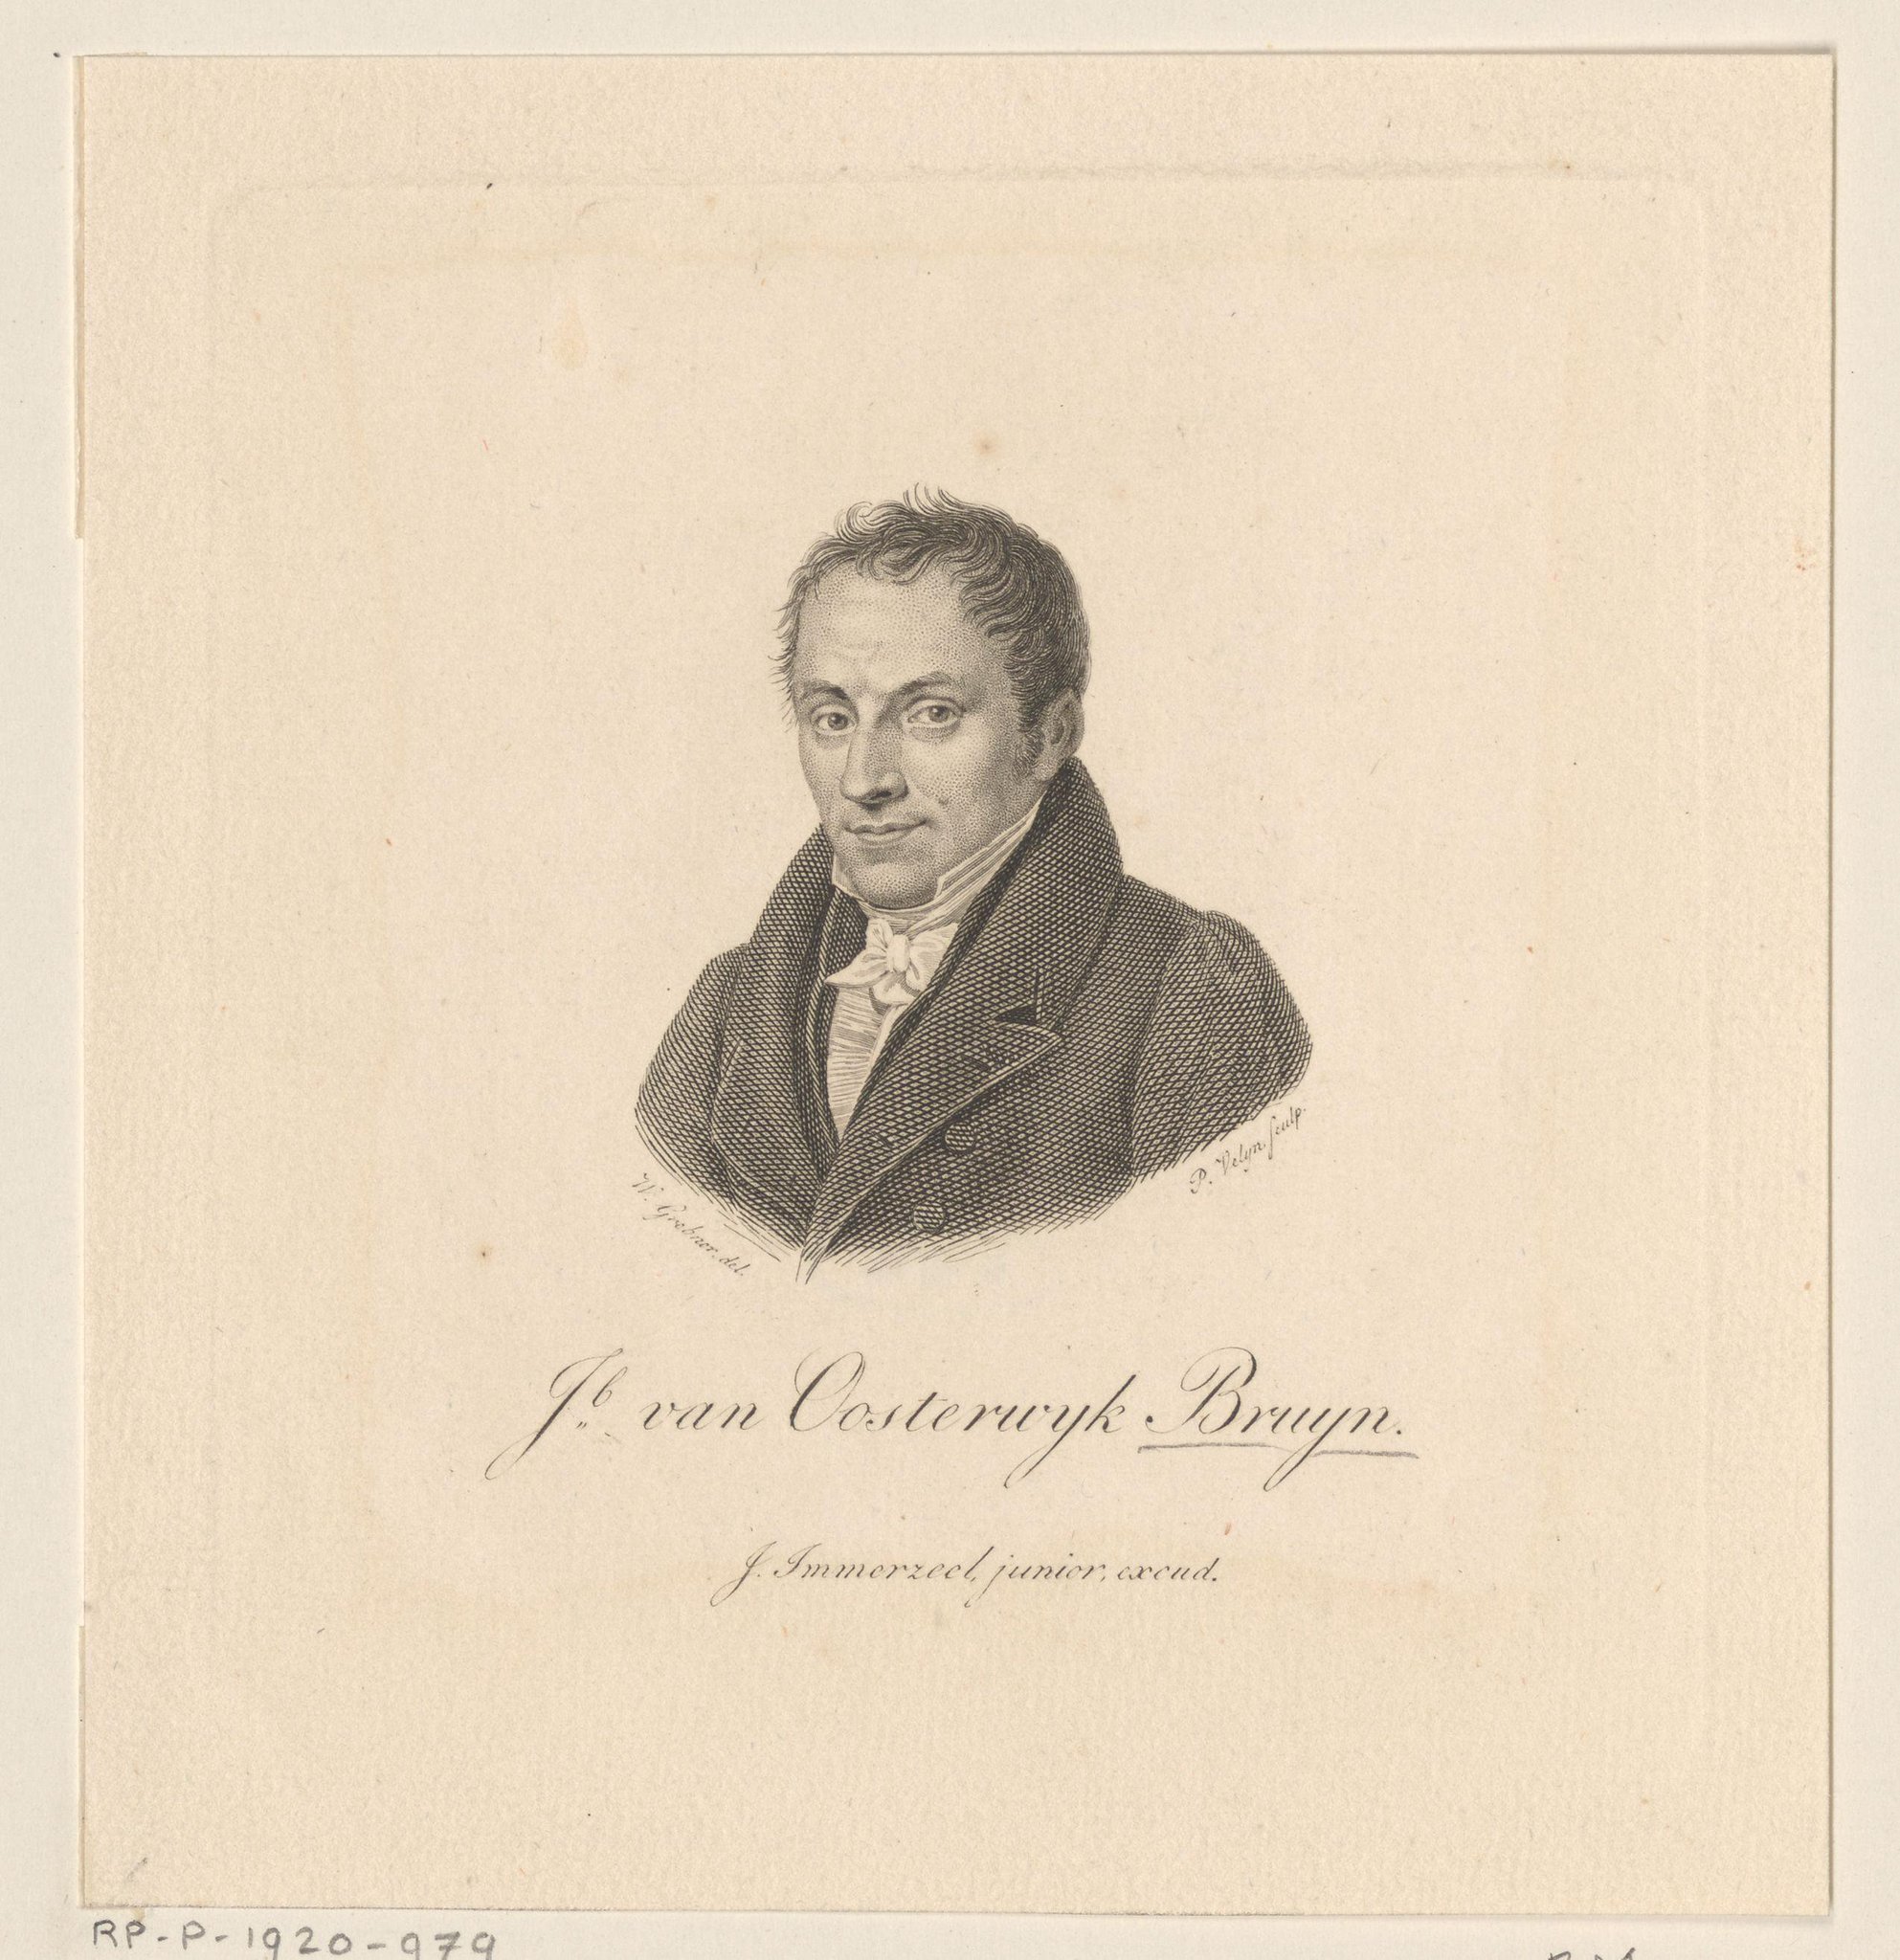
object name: print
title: Portret van Jacob van Oosterwijk Bruyn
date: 1815-1836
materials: paper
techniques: engraving, etching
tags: amsterdam, historical persons, writer, poet, author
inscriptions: collector's mark: Lugt 2228